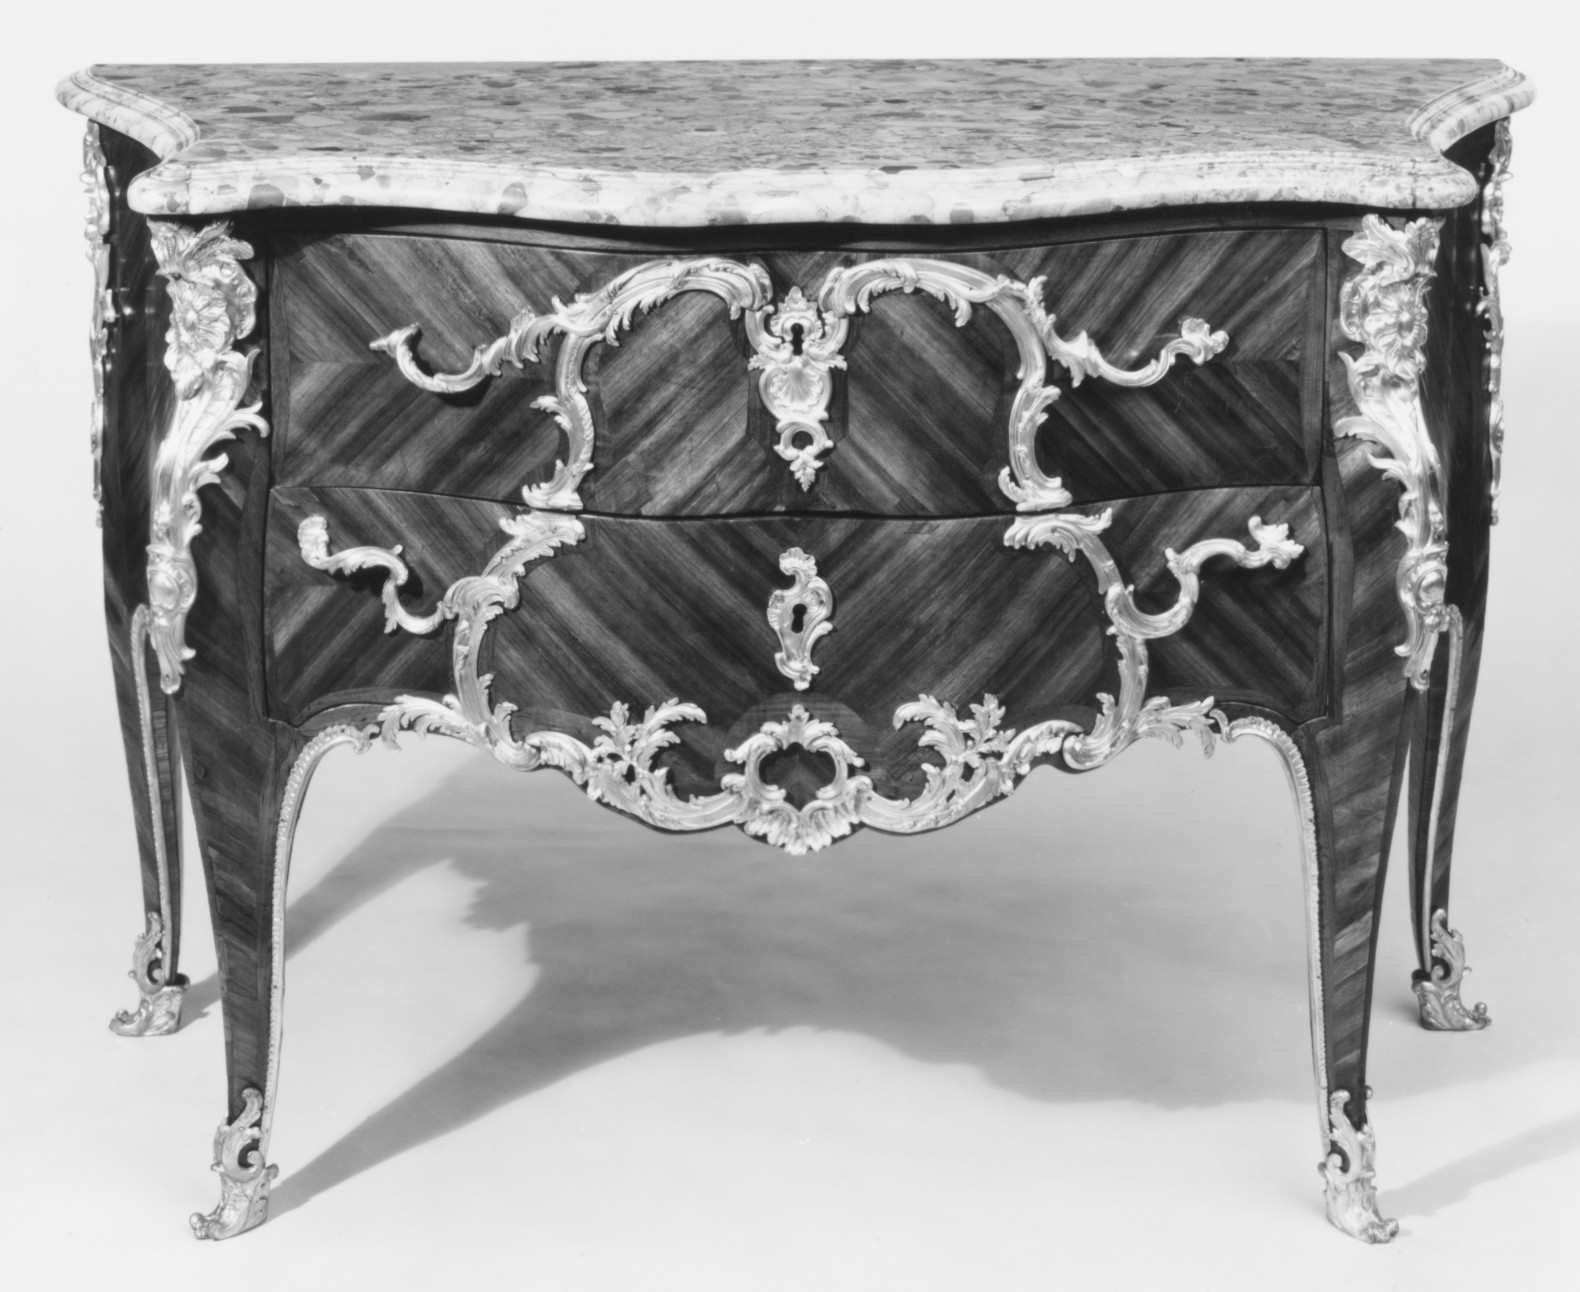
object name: commode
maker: antoine-mathieu criaerd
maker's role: maker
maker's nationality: french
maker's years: 1724-1787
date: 1745-1749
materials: gilt bronze, marble, wood